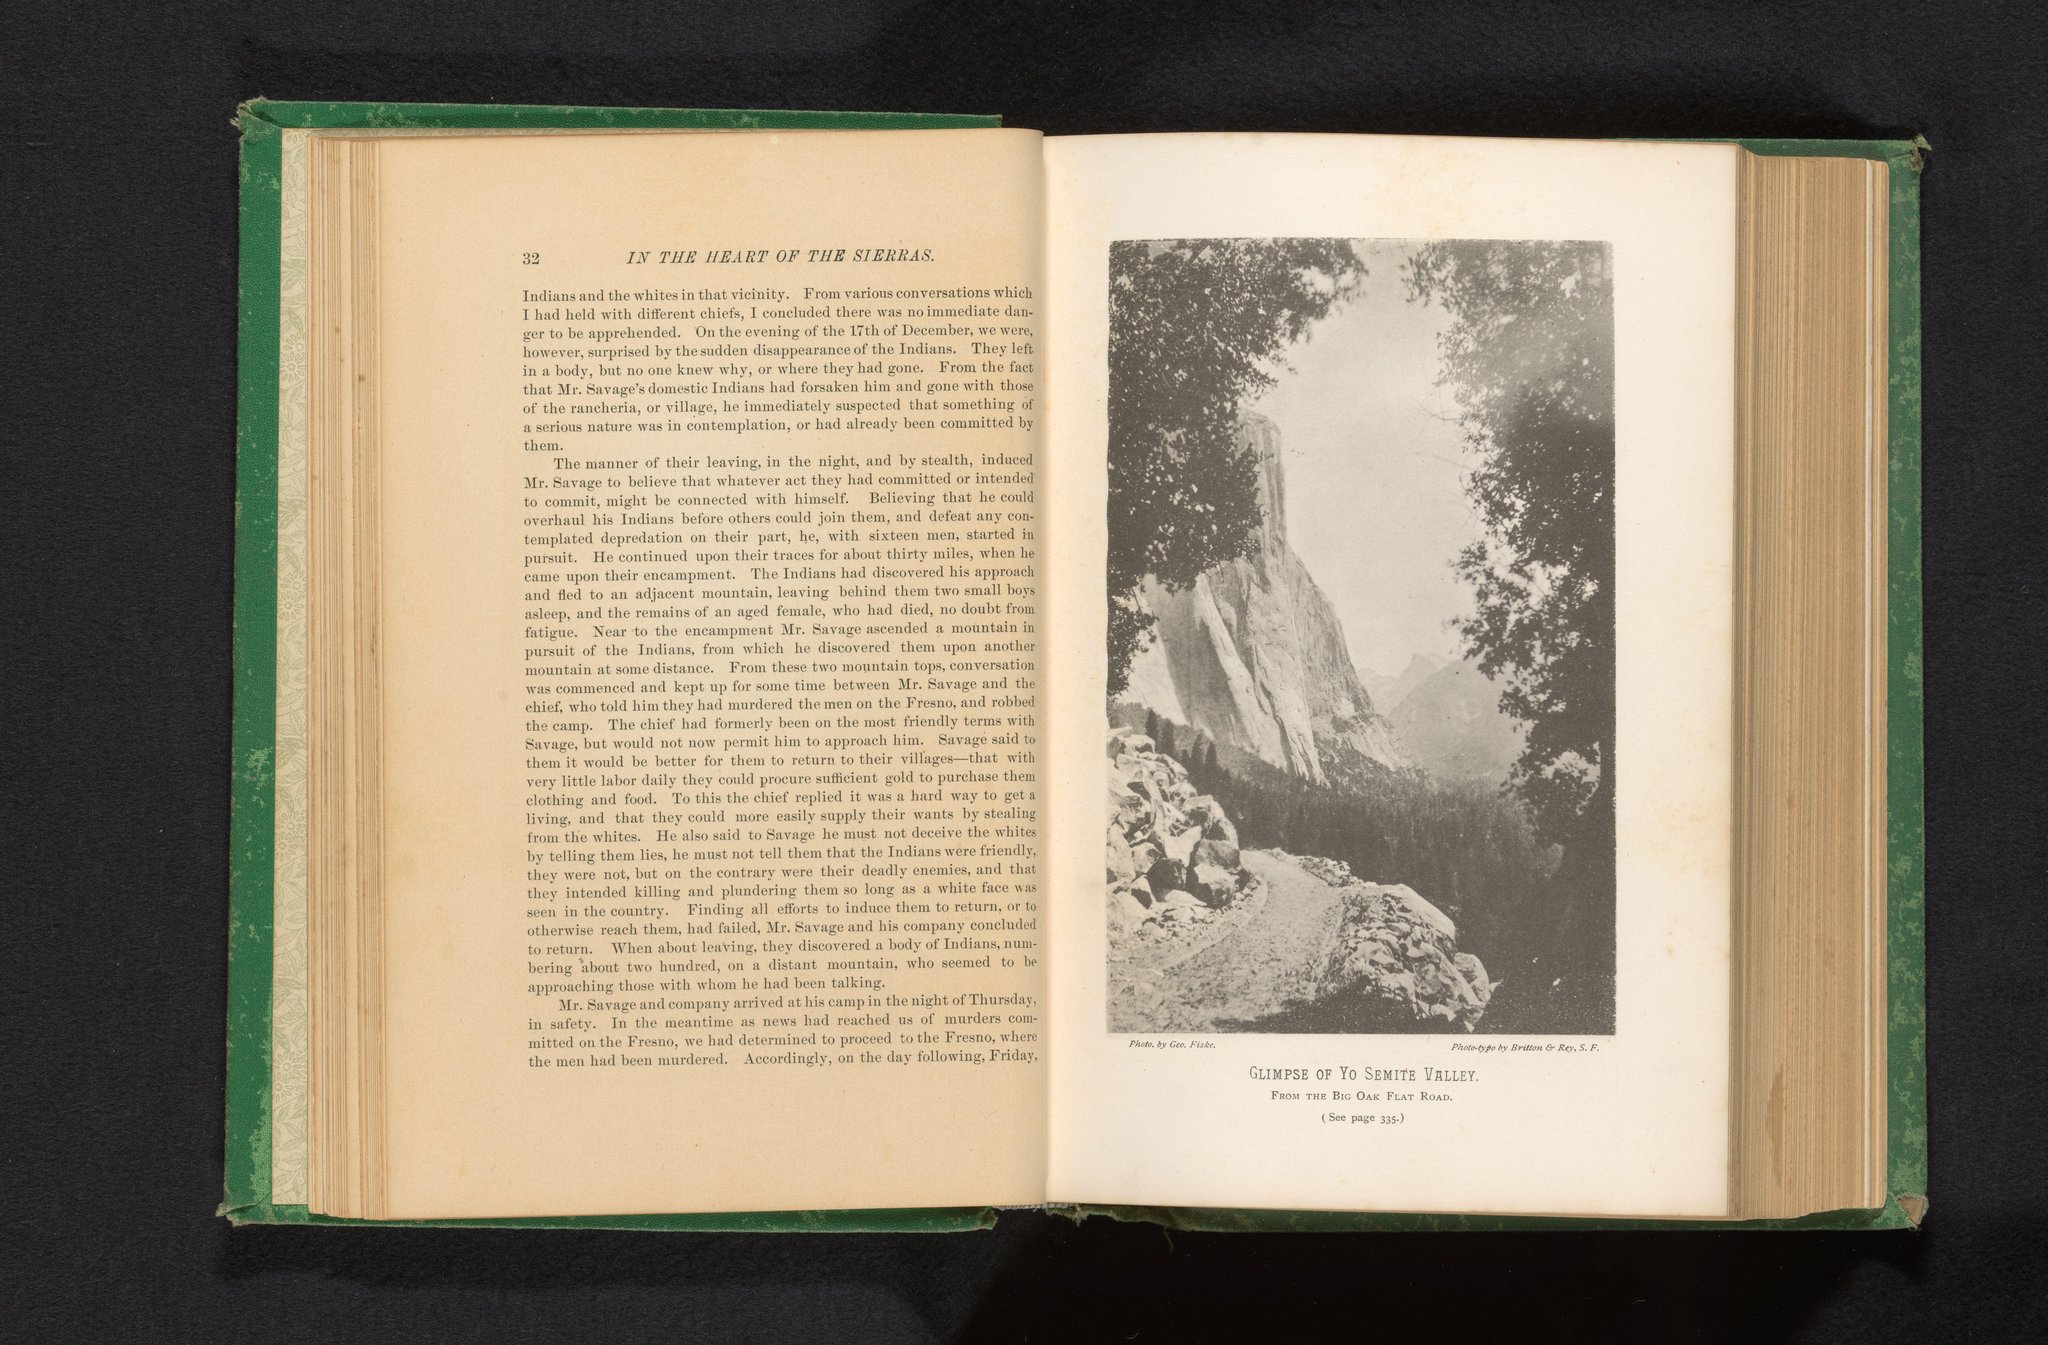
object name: photomechanical print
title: Glimpse of Yo Semite Valley, from the Big Oak Flat Road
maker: george fiske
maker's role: fotograaf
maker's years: 1835-1918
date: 1881-1886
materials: paper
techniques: photograph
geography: yosemite valley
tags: dale, valley, mountains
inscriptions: inscription: ‘(See page 335.)’